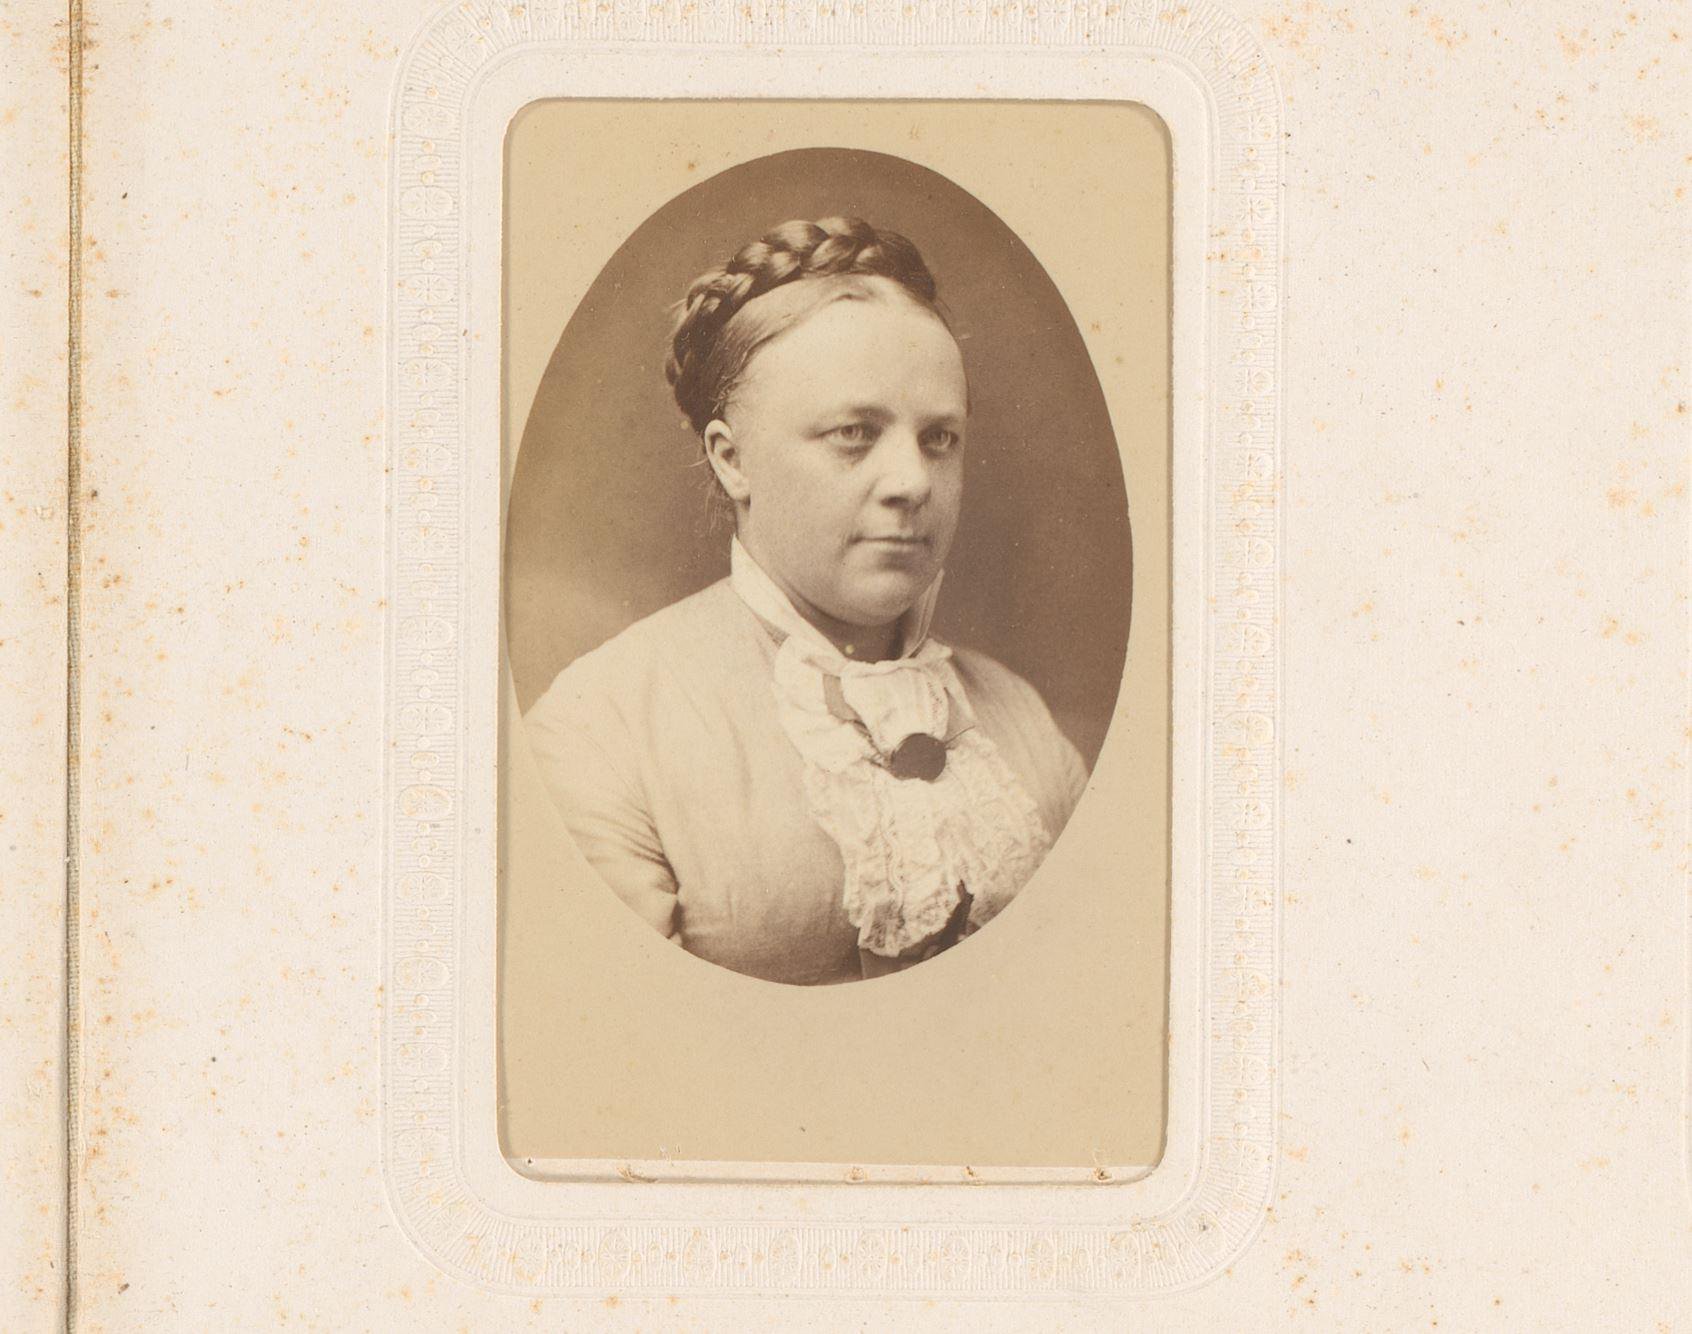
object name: album leaf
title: Portret van een vrouw met vlecht in het haar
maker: Anonymous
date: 1860-1900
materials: cardboard, photographic support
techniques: albumen print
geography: netherlands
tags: historical persons - bb - woman, hairdress